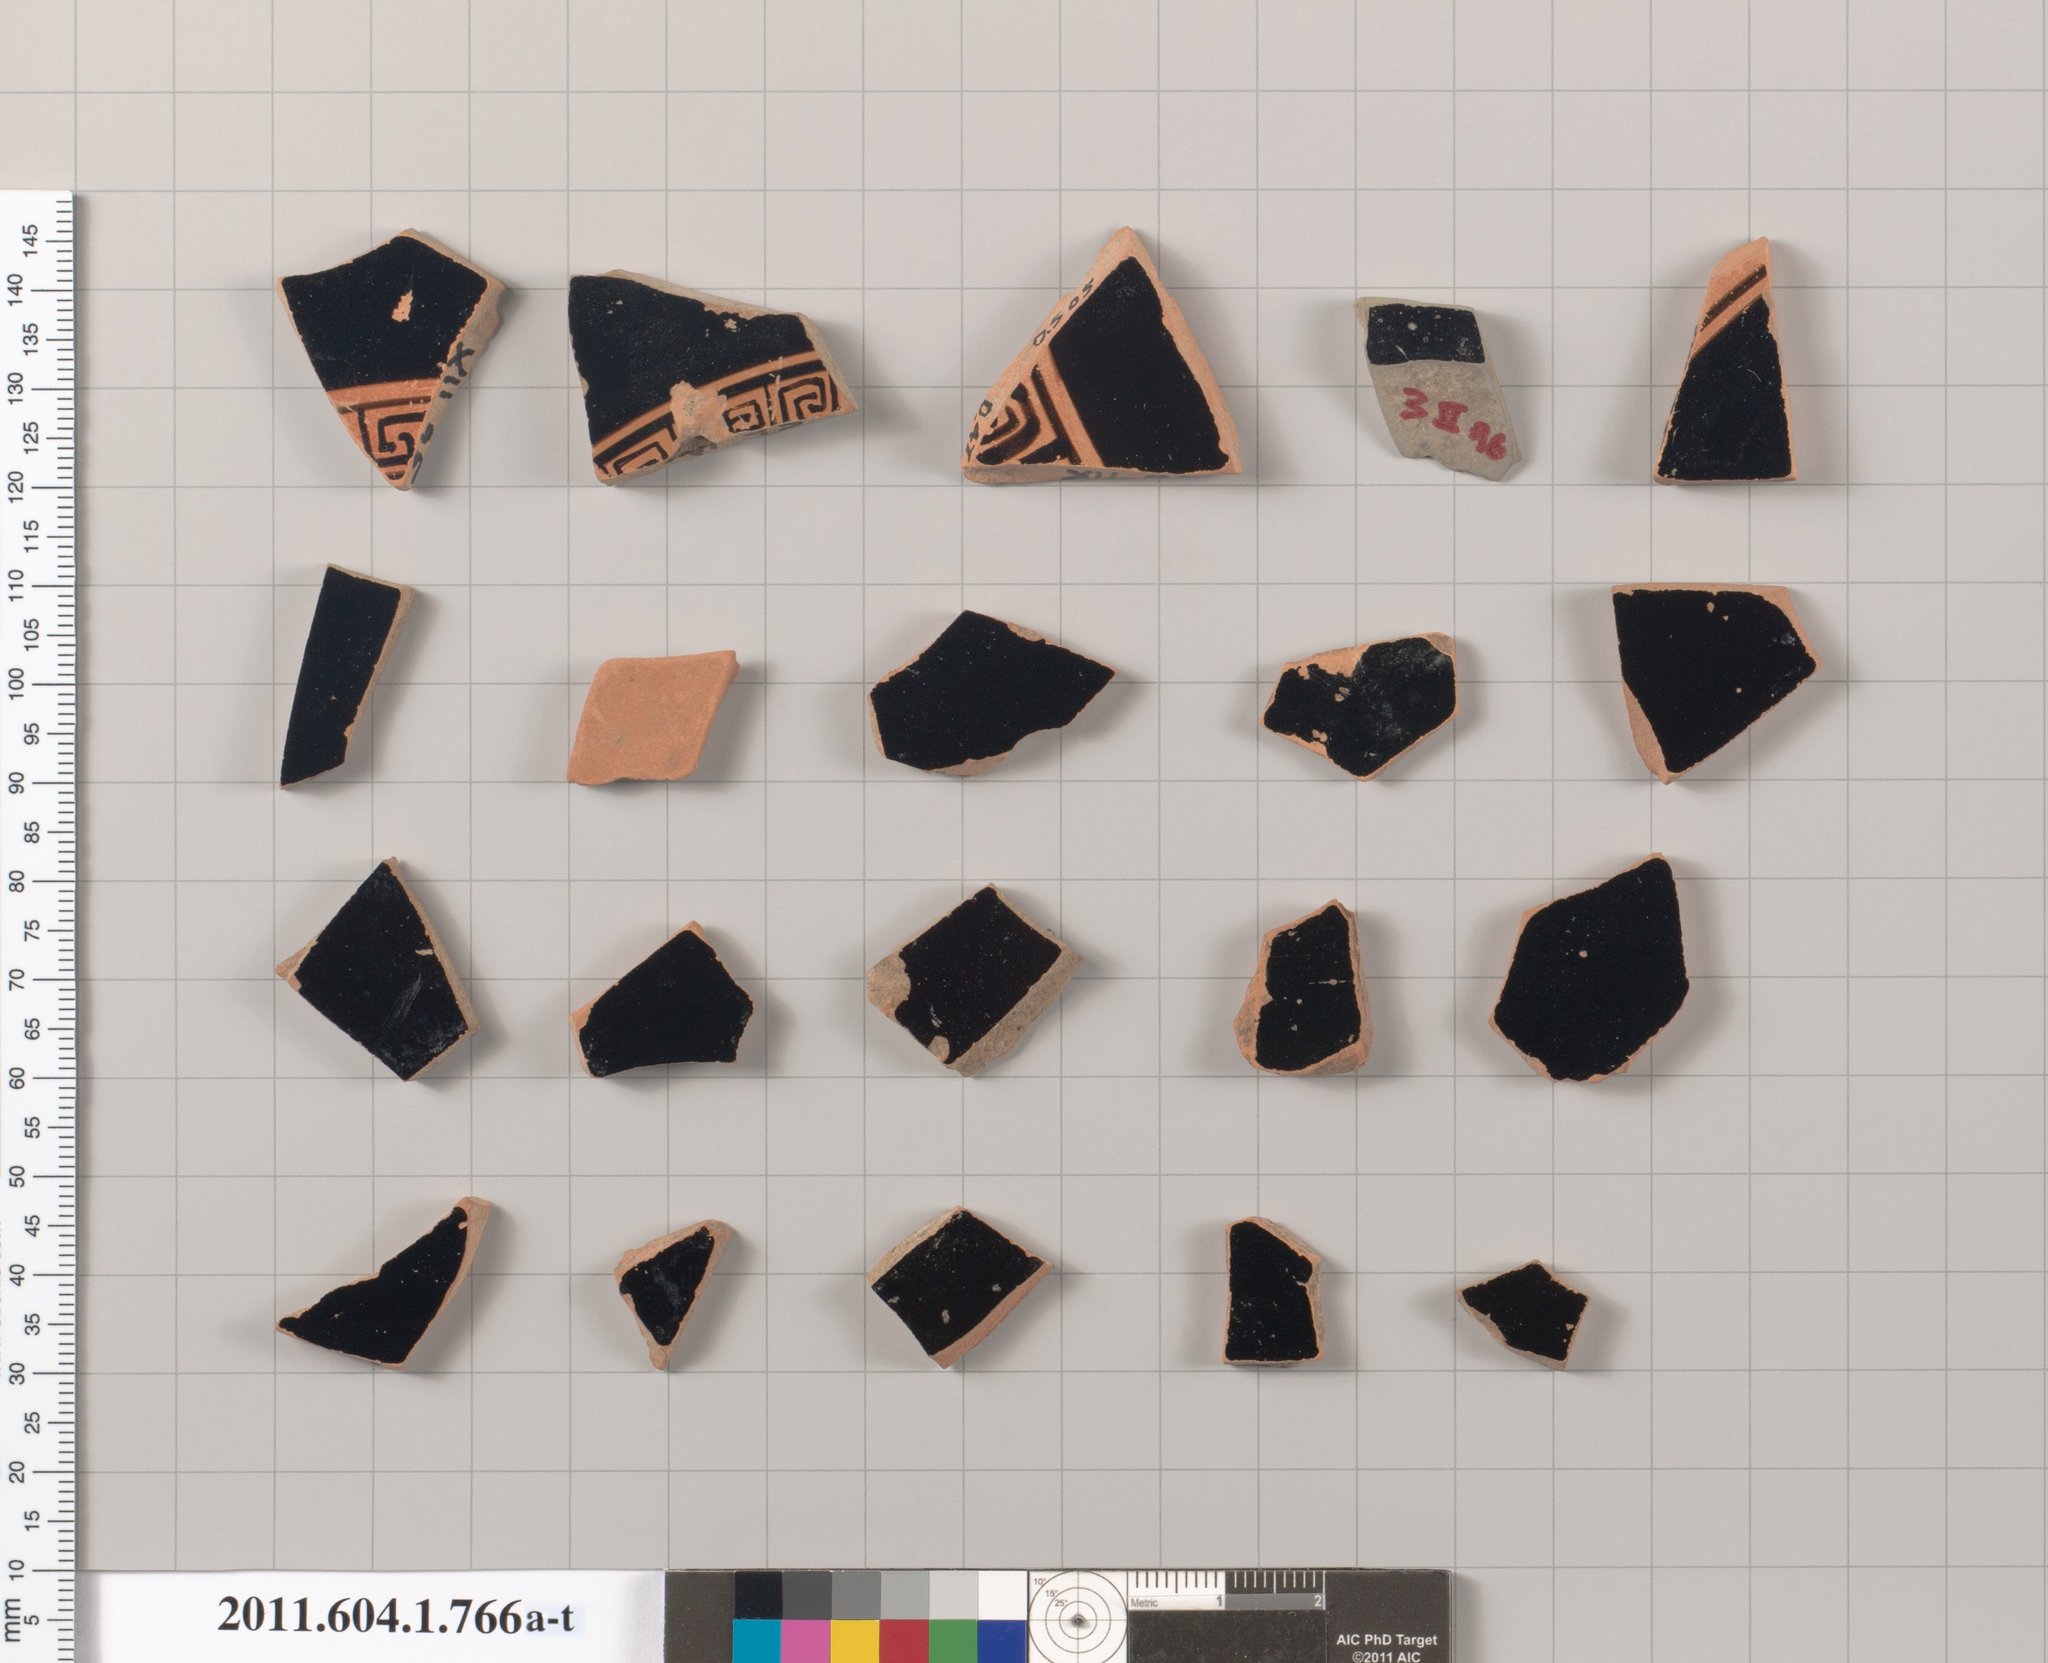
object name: kylix fragment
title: Terracotta fragments of kylikes (drinking cups)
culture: greek, attic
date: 500-401 BCE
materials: terracotta